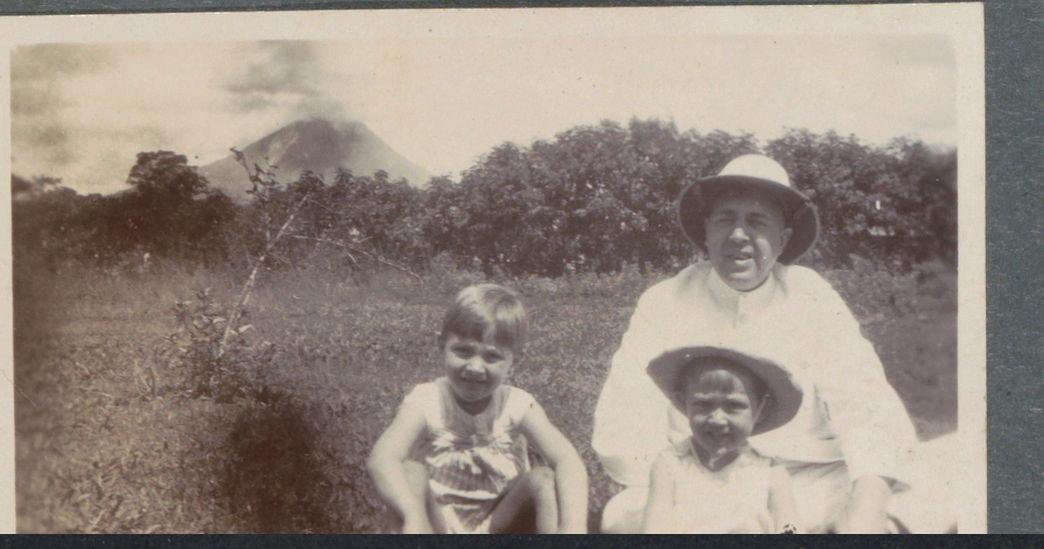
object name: photograph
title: Man met kinderen in een veld op Sumatra, op de achtergrond een vulkaan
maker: Anonymous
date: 1914-1926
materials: photographic support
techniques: gelatin silver print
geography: sumatra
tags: father and child(ren), man and child(ren) (family group), sumatra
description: Onderdeel van fotoalbum met opnames van de familie Bergsma in Tandjong Poera en Rantan Pandjang (Sumatra).